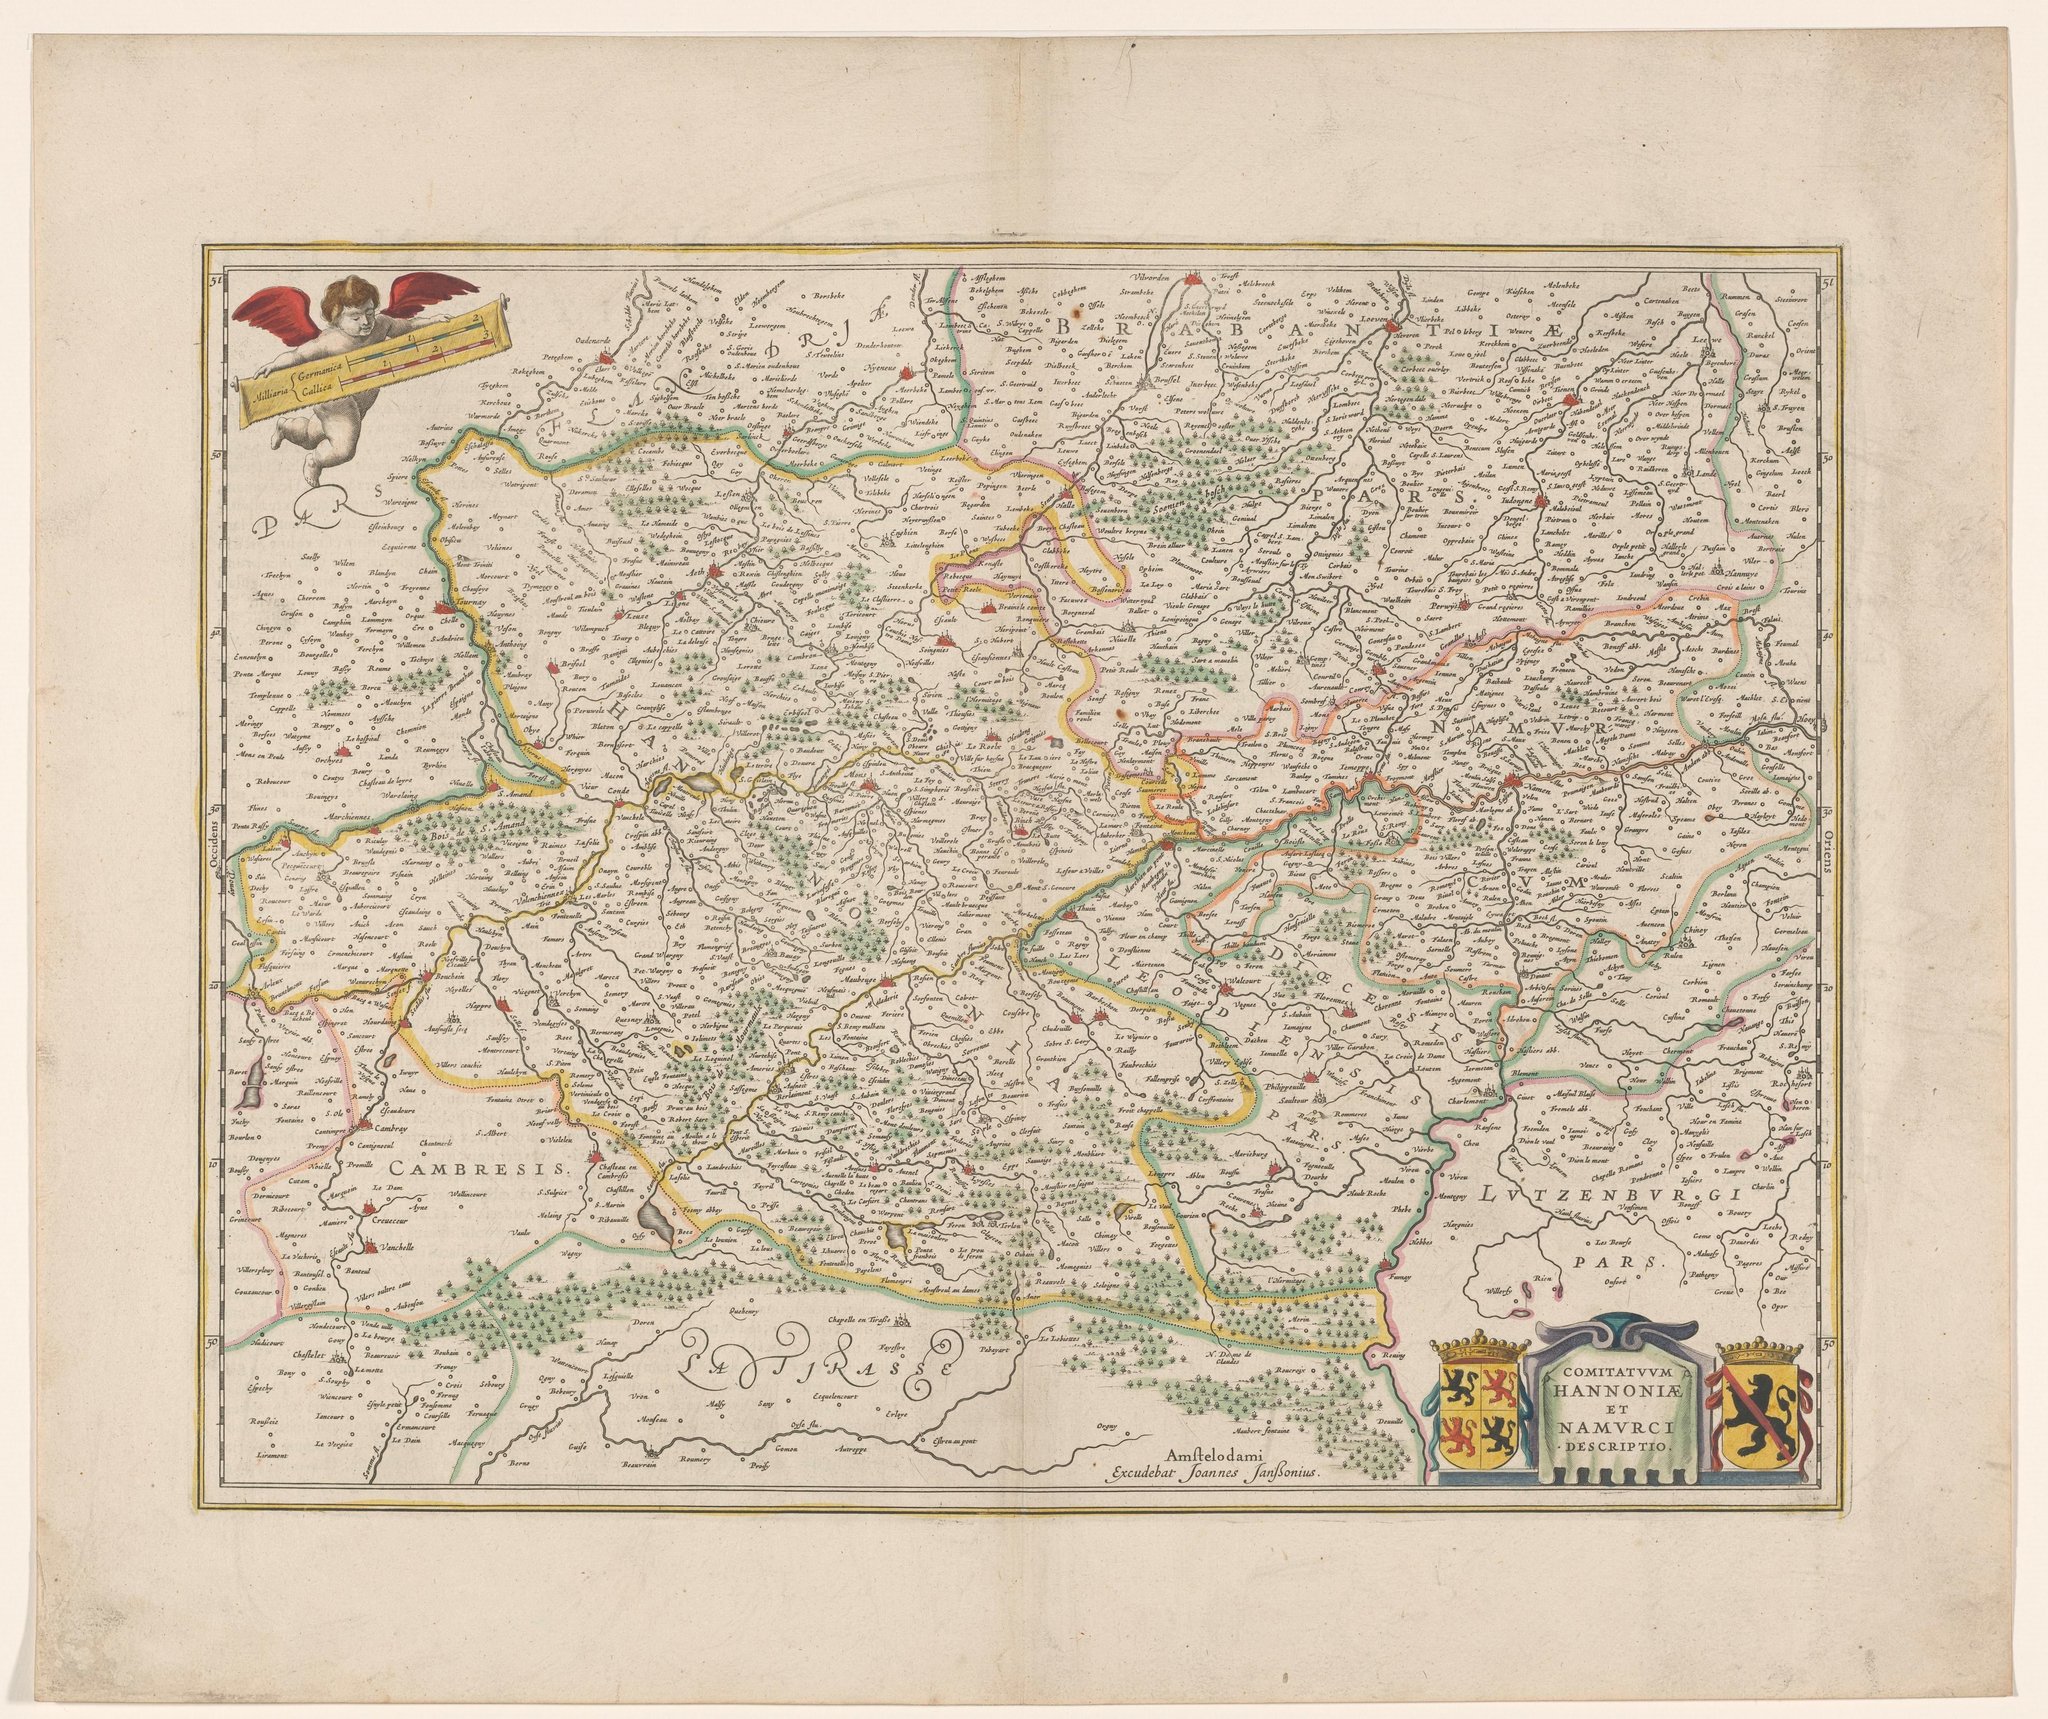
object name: map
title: Kaart van de graafschappen Henegouwen en Namen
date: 1666-1675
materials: paper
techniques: engraving, hand coloring, letterpress printing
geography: amsterdam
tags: maps of separate countries or regions, coat of arms (as symbol of the state, etc.) (+ province; provincial), namur, henegouwen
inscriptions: collector's mark: Lugt 2228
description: Kaart van de graafschappen Henegouwen en Namen. Rechtsonder de titelcartouche met links het wapen van Henegouwen en rechts het wapen van Namen. Linksboven een putto met een banderol met daarop twee schaalstokken: 2 Milliaria Germanica / 3 Milliaria Gallica. De kaart is voorzien van een gradenverdeling langs de linker- en rechterrand. Met Latijnse tekst op verso.